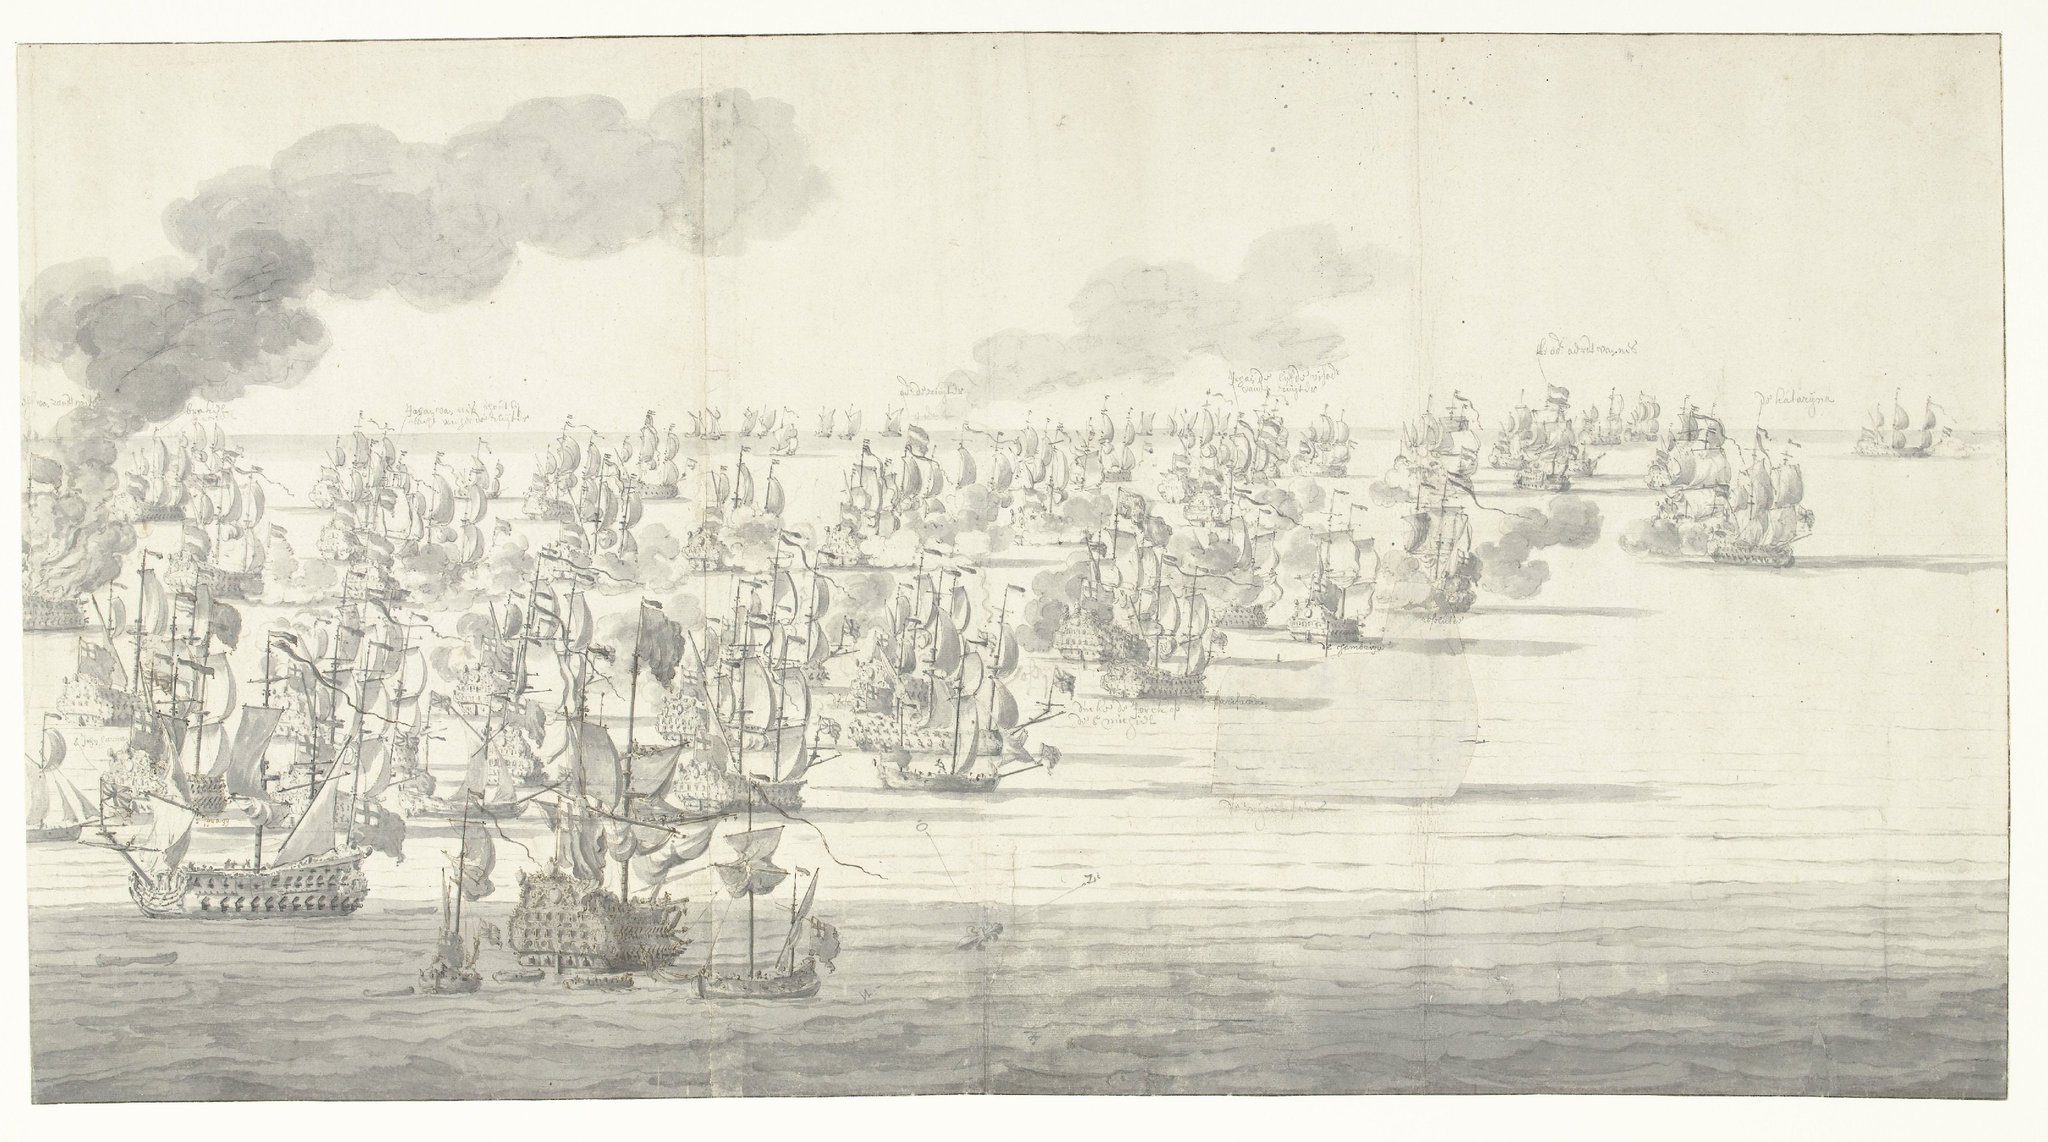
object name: drawing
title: De Slag bij Solebay, 7 juni 1672, even na twee uur in de middag, gezien vanuit het noordwesten: rechterdeel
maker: willem van de velde (i)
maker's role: draughtsman, painter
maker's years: 1611-1693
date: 1673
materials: ink, paper, pencil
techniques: brush, pen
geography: northern netherlands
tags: sailing-ship, sailing-boat, sea (seascape), battle (+ sailing-ships), navy (+ sailing-ships), battle of solebay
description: De Slag bij Solebay, 7 juni 1672, even na twee uur in de middag, gezien vanuit het noordwesten: rechterdeel. Deze uit twee delen bestaande tekening geeft een moment uit de Slag van Solebay in 1672 weer. In dit openingsgevecht van de derde Engelse Zeeoorlog vocht de Staatse vloot onder leiding van admiraal De Ruyter tegen de gecombineerde Engels-Franse vloot voor de kust van Suffolk, ter hoogte van Solebay. Net als bij eerdere zeeslagen voer Willem van de Velde aan boord van zijn galjoot aan Nederlandse zijde mee. De zeeslag is in volle gang. Het linkerblad toont onder meer de Dolfijn, het schip van luitenant-admiraal Willem Joseph, baron Van Ghent die bij deze slag om het leven zou komen. Het brandende schip Royal James staat deels op het linker- en deels op het rechterdeel. Dit fregat van admiraal Edward Mountagu, Earl of Sandwich, werd omstreeks twee uur in de middag door een Hollandse brander geraakt. De Royal Prince, het vlaggeschip van de hertog van York dat al voor de middag zo beschadigd werd dat de hertog zijn vlag moest overbrengen naar de St. Michael, was oorspronkelijk door Van de Velde rechtsboven de zuidas van de windroos geplaatst, maar werd door hem met een stukje papier weer afgedekt.